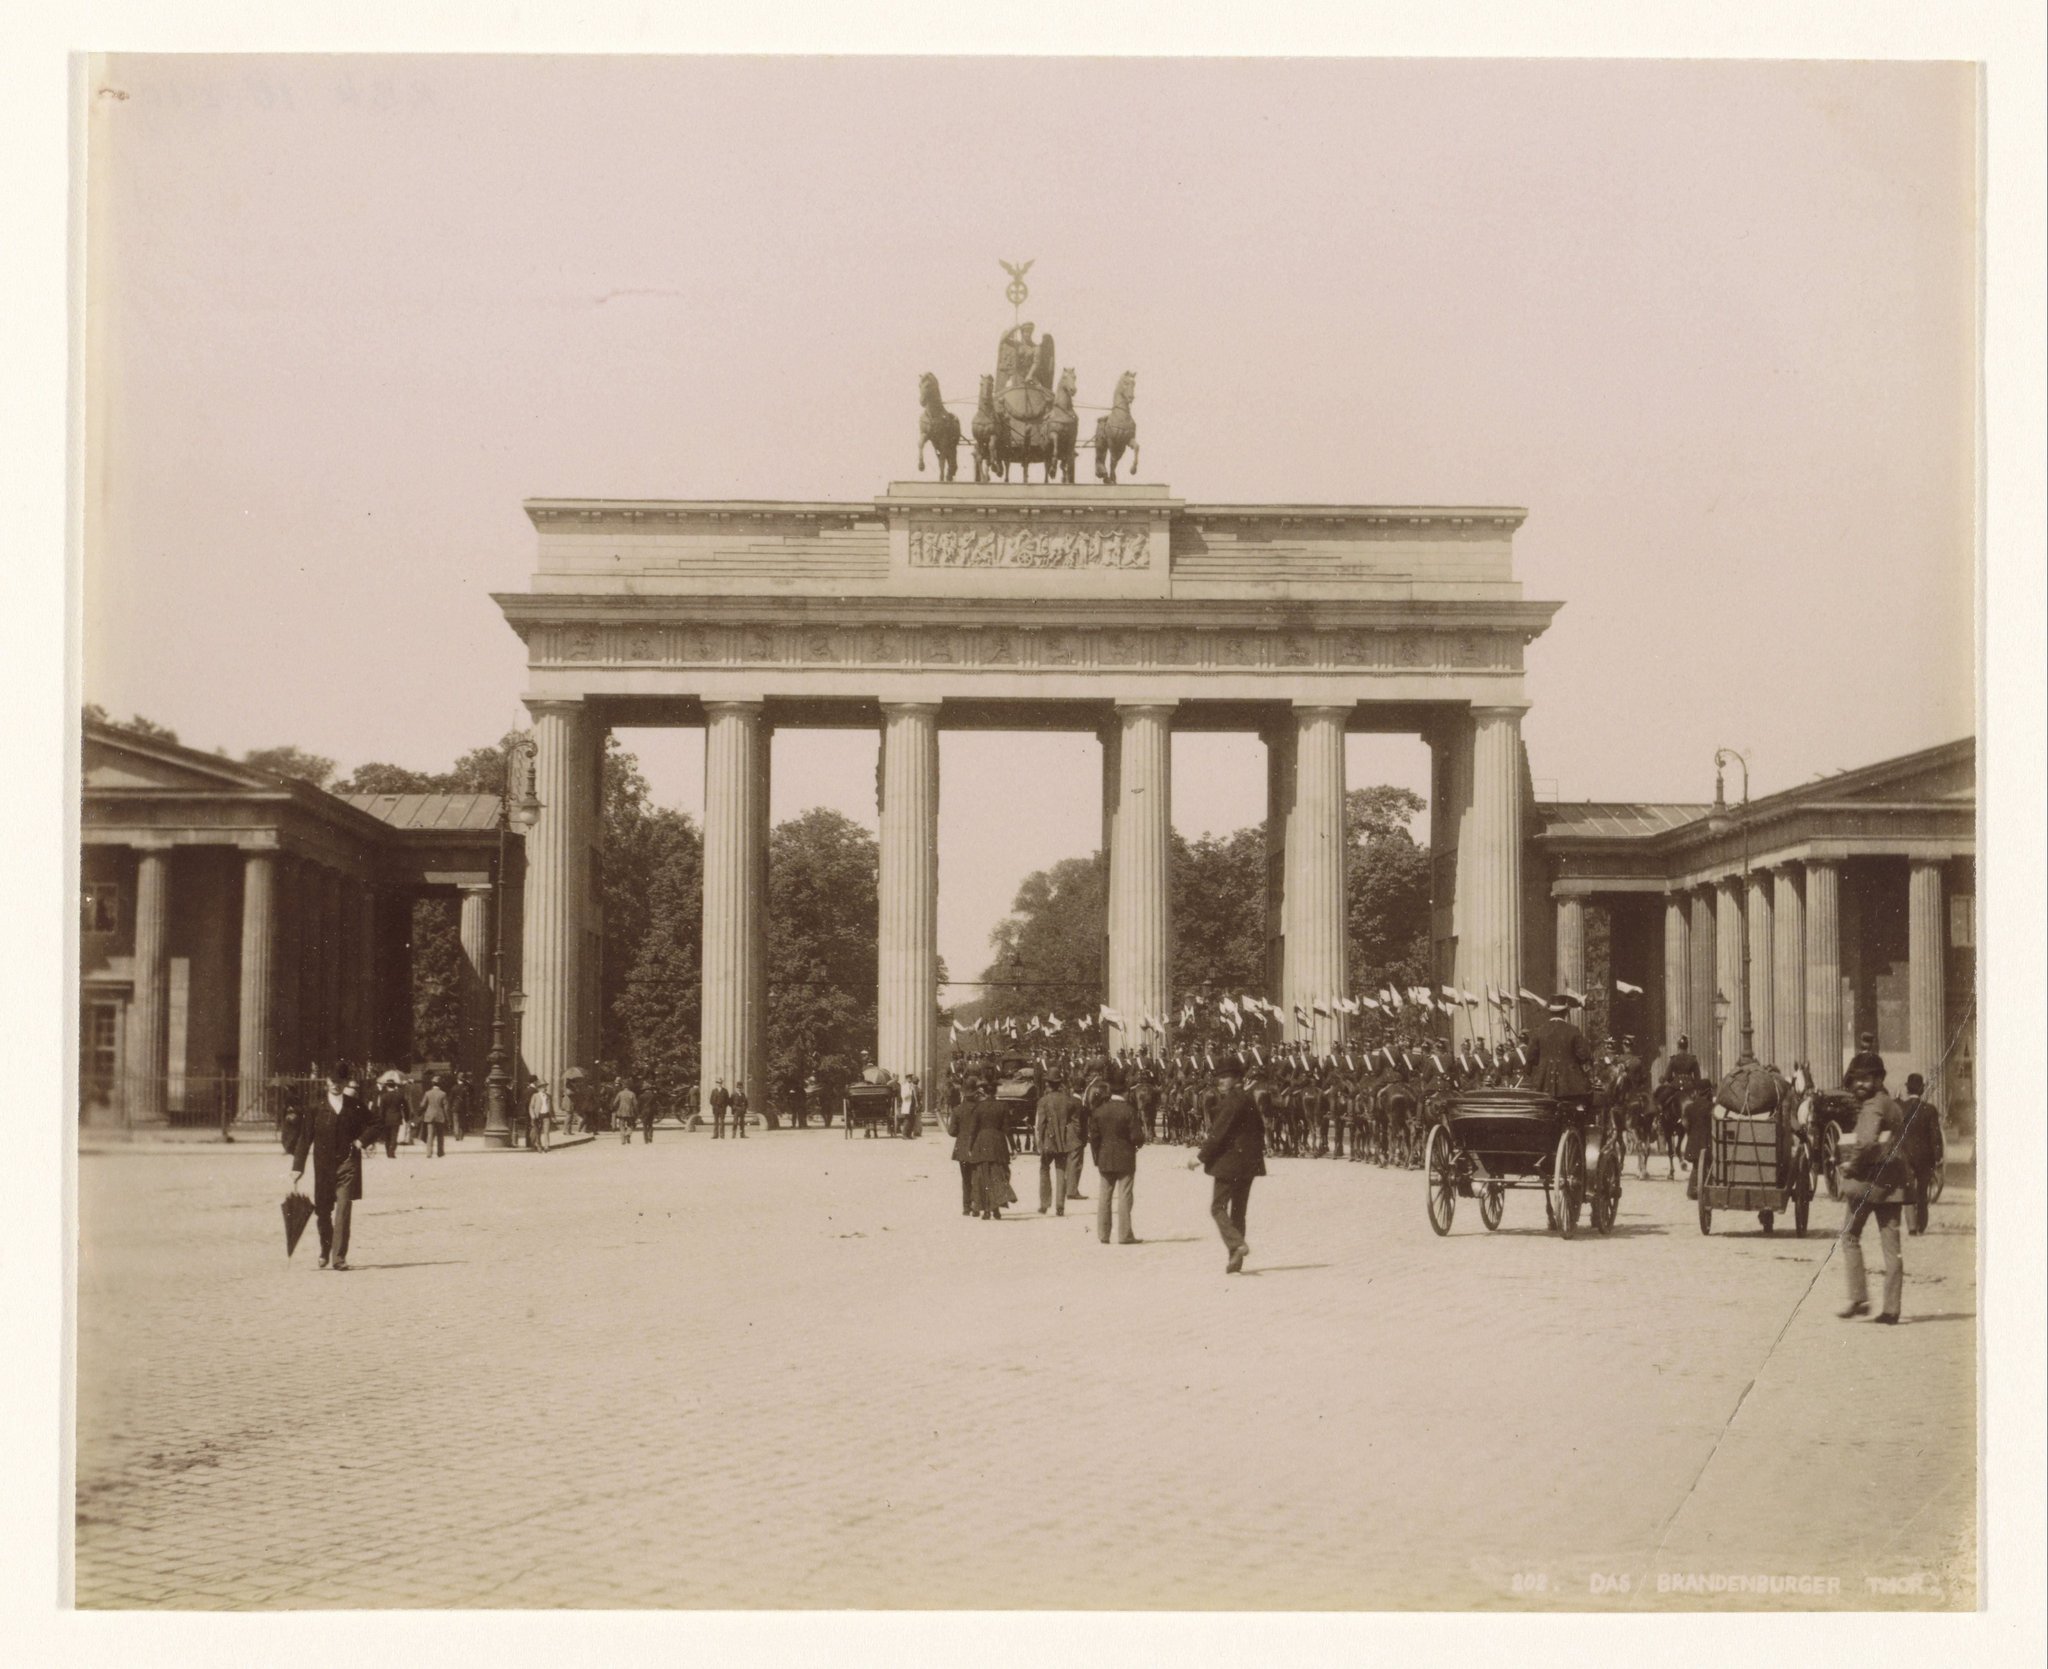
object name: photograph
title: Das Brandenburger Thor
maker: friedrich albert schwartz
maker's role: fotograaf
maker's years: 1836-1906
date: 1860-1890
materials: paper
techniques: albumen print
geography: berlin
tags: square, place, circus, etc., gate, entrance, military parade, pageant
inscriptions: check stamp: ‘[...] Gesellschaft/ Albert [...]’, inscription: ‘202. Das Brandenburger Thor’